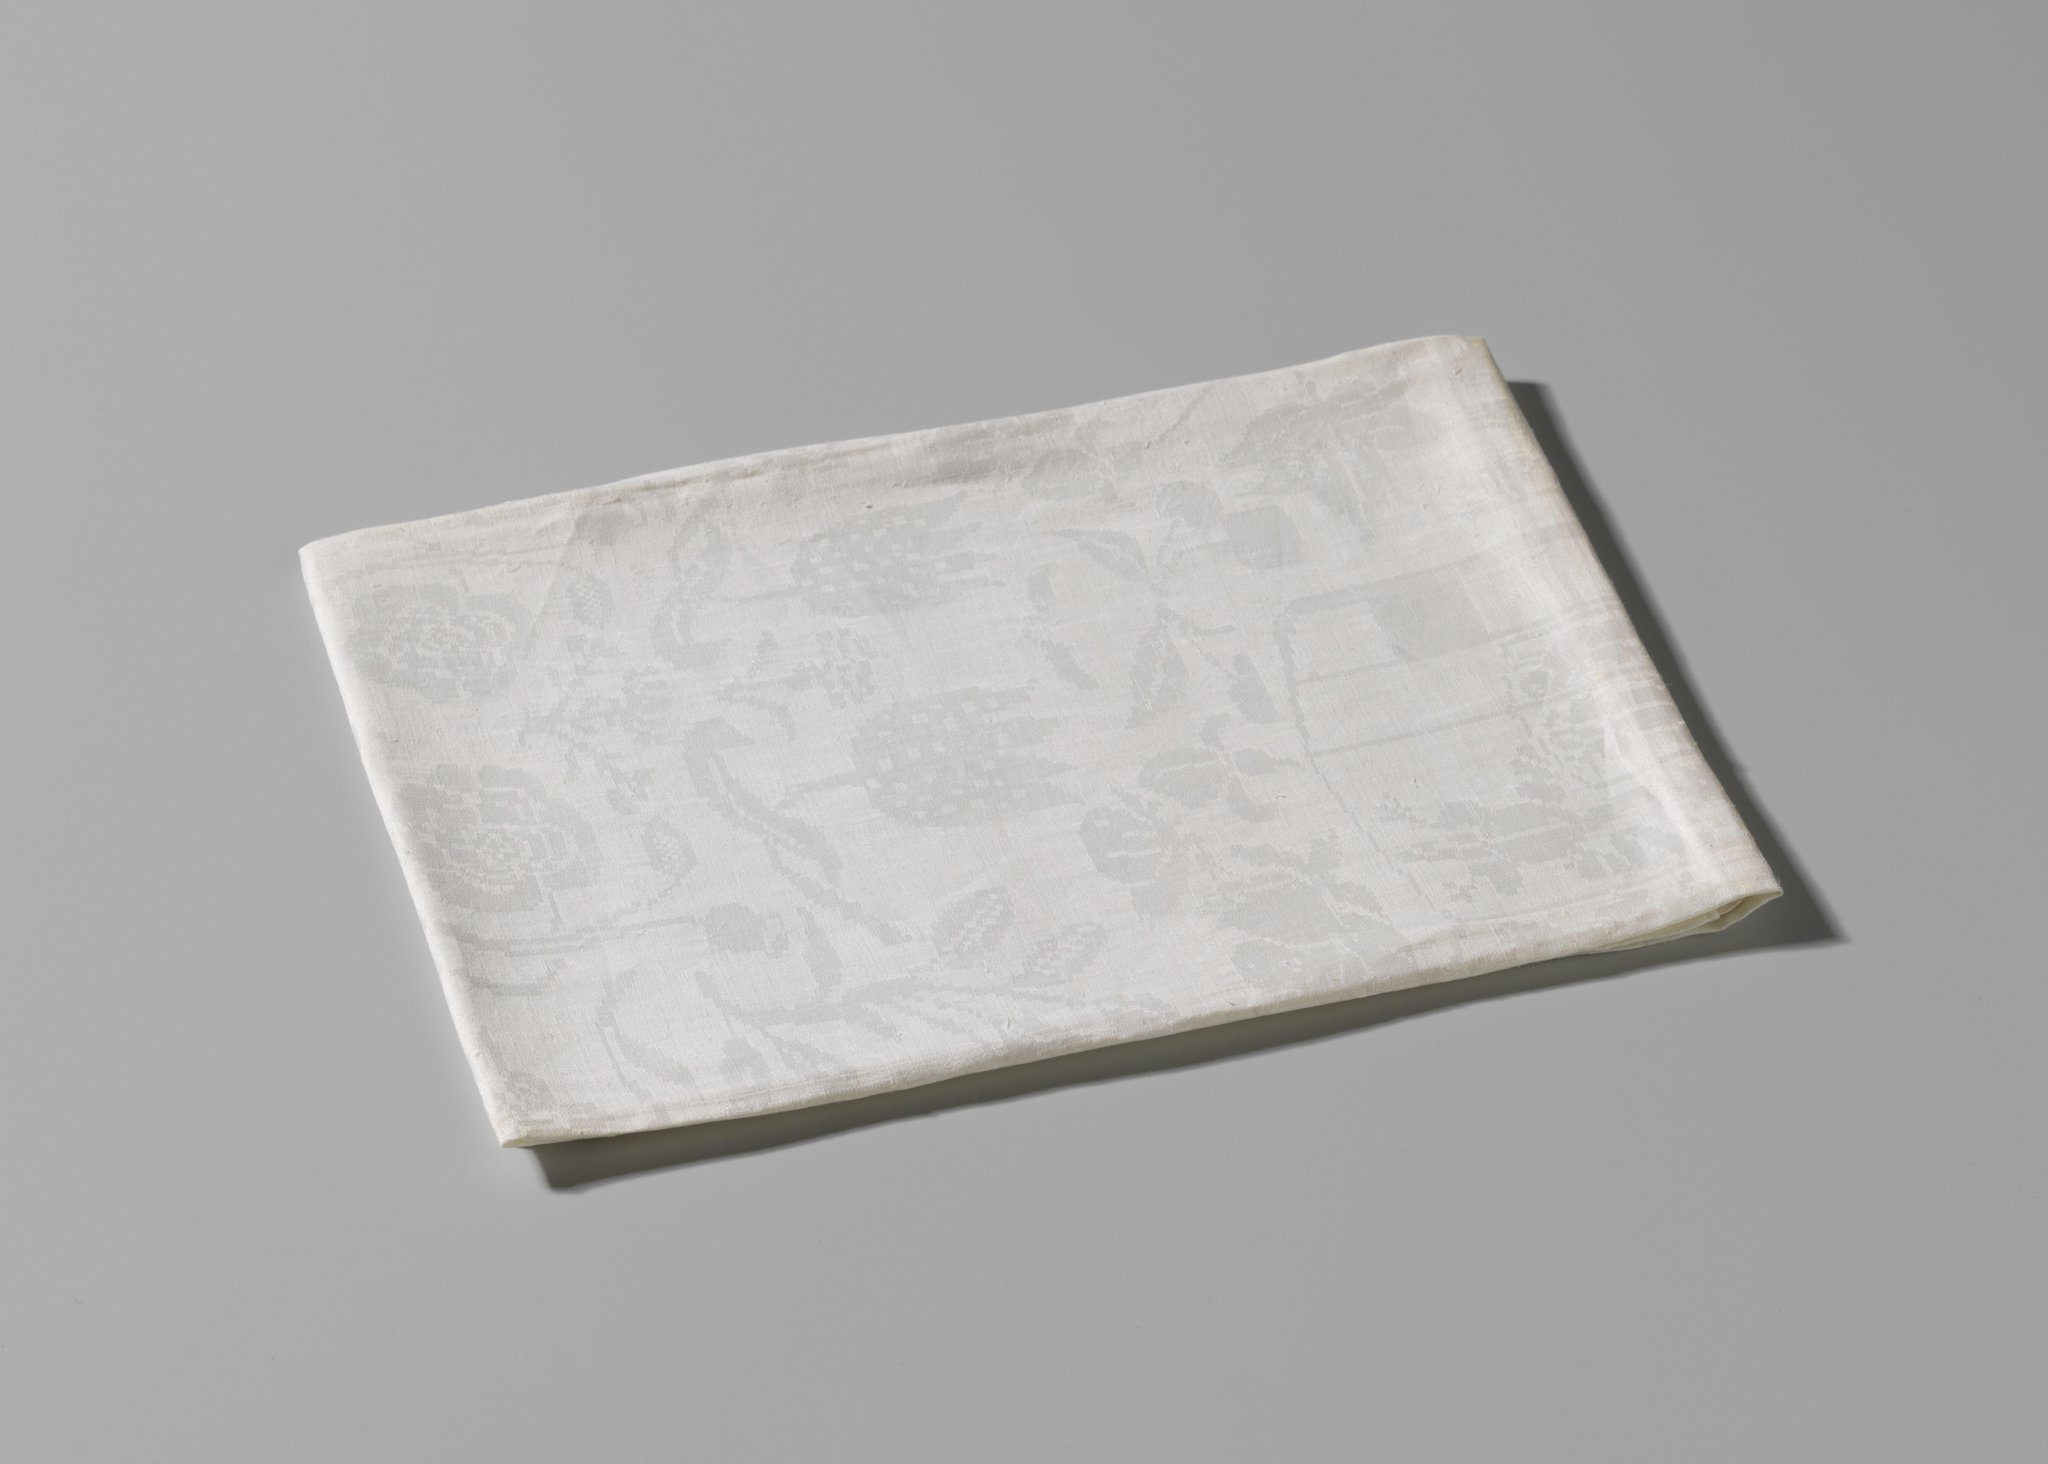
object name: woven material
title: Servet van wit linnendamast met de gekoppelde wapens Von Inn- und Kniphausen en Van Ewsum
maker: Anonymous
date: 1665-1670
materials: linen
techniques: damask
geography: northern netherlands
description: Servet van wit linnendamast met bloempatroon romdom de gekoppelde wapens Von Inn- und Kniphausen en Van Ewsum. Gemerkt: kroon LE 17.